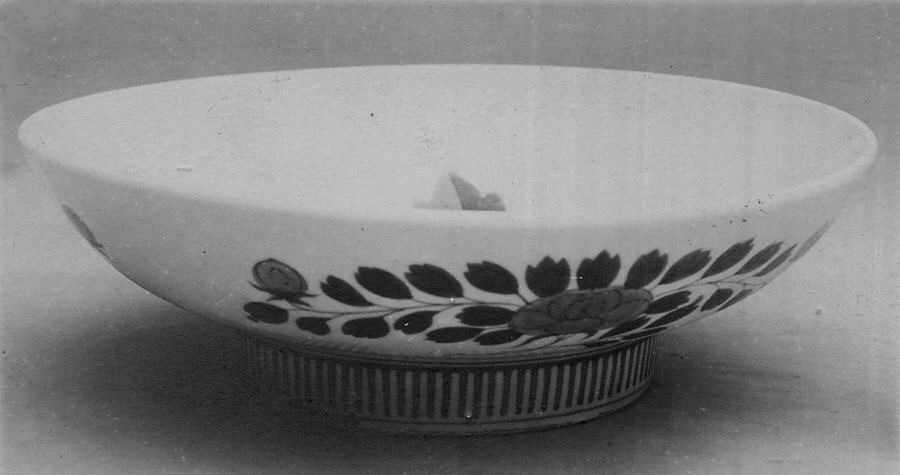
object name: dish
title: Large Dish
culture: japanese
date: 1780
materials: glaze, porcelain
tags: flowers